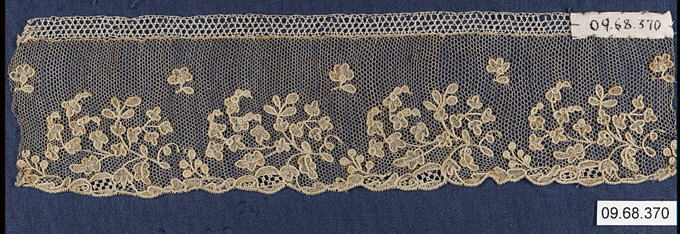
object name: fragment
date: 1801-1900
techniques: lace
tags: flowers